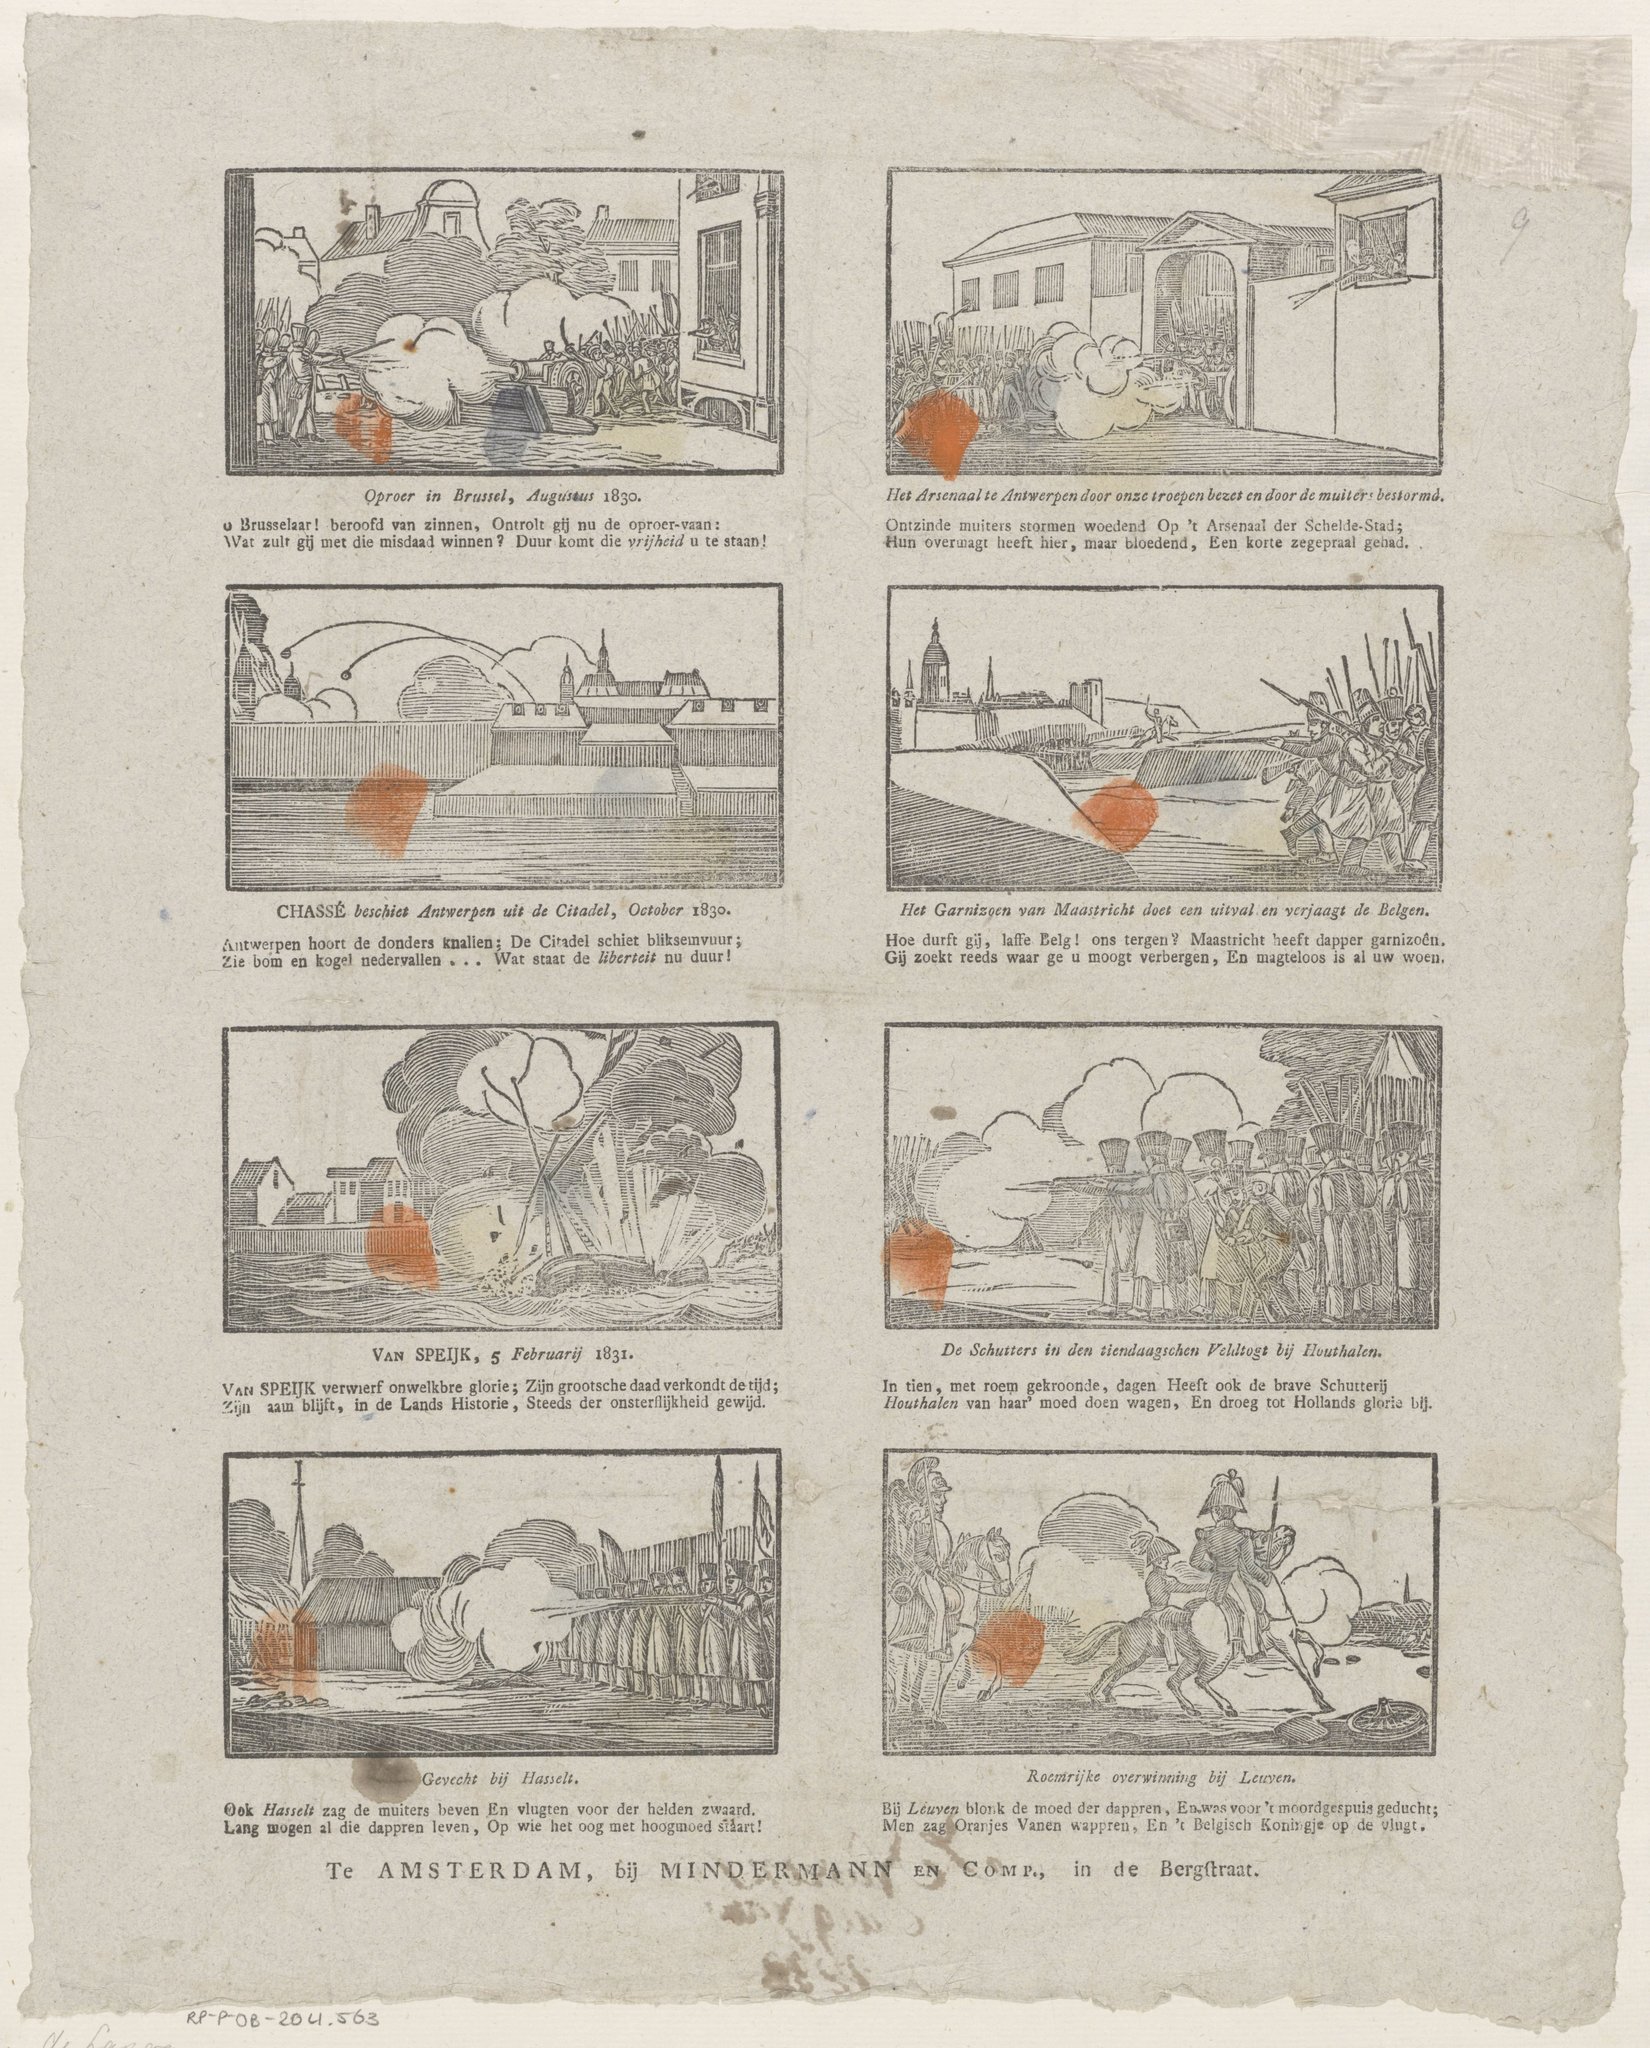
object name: popular print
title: Strijd tegen de Belgen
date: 1822-1849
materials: paper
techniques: colour, letterpress printing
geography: netherlands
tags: antwerp, jan van speyk, battle, revolution, revolt, tailor, dressmaker, orphans, netherlands, belgium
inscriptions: collector's mark: Lugt 2760, inscription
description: Blad met 8 voorstellingen over de strijd tegen de Belgen en de zelfopoffering van J.C.J. van Speyk. Onder elke afbeelding een onderschrift.